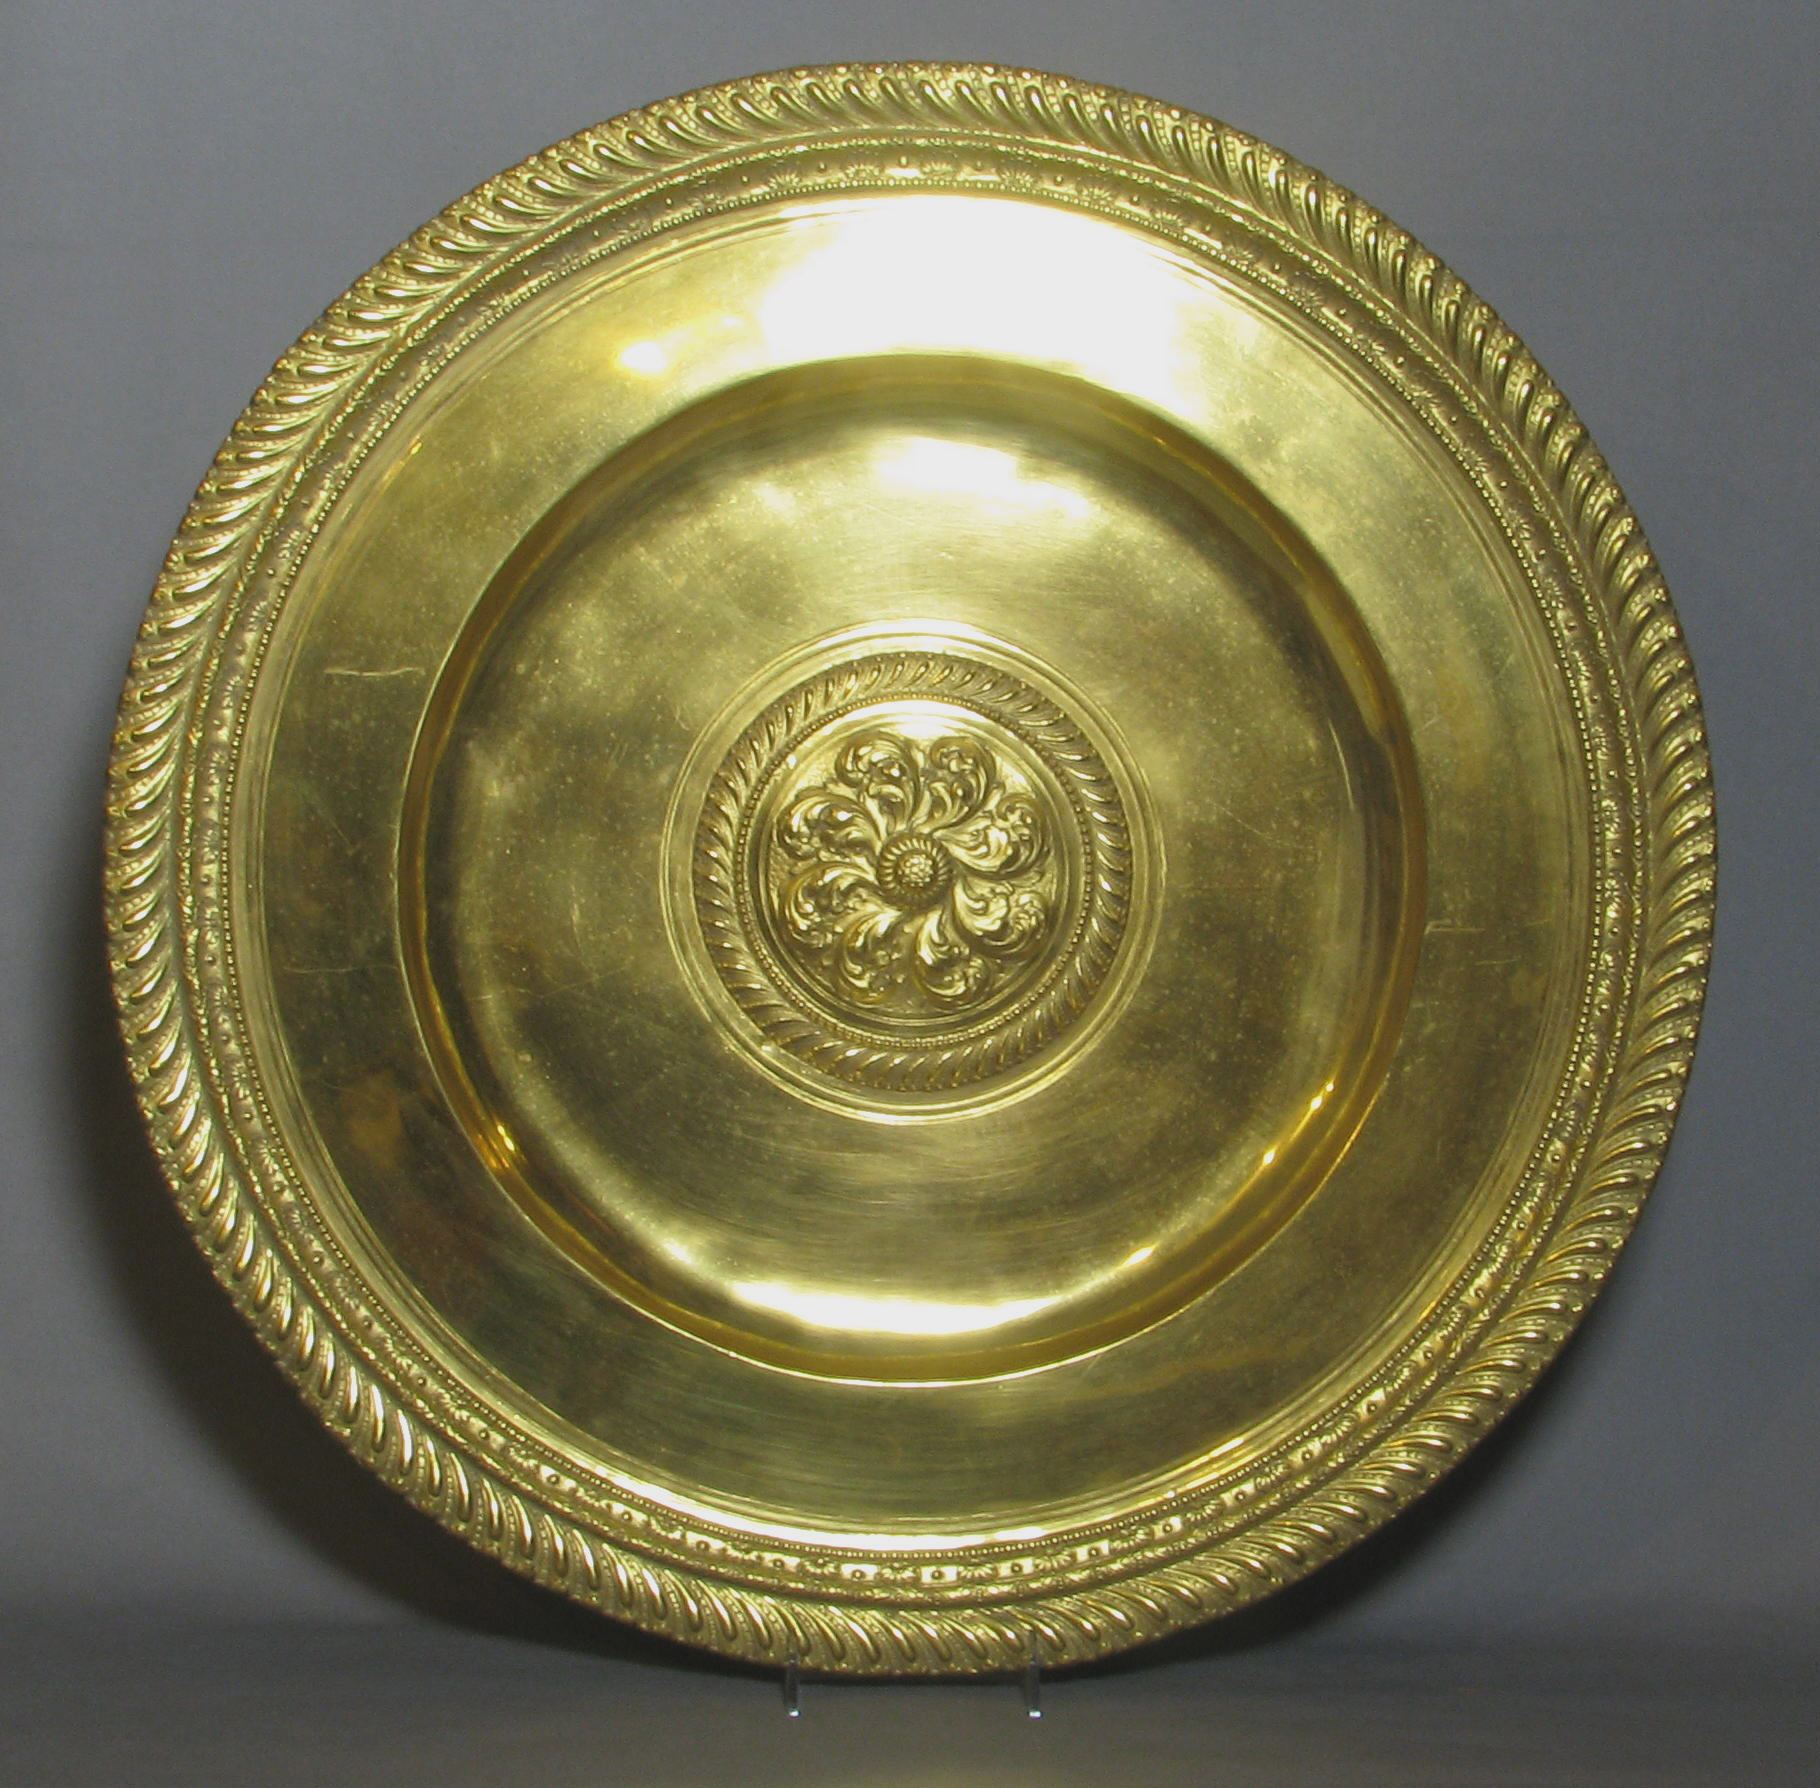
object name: salver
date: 1801-1900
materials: metal, silver